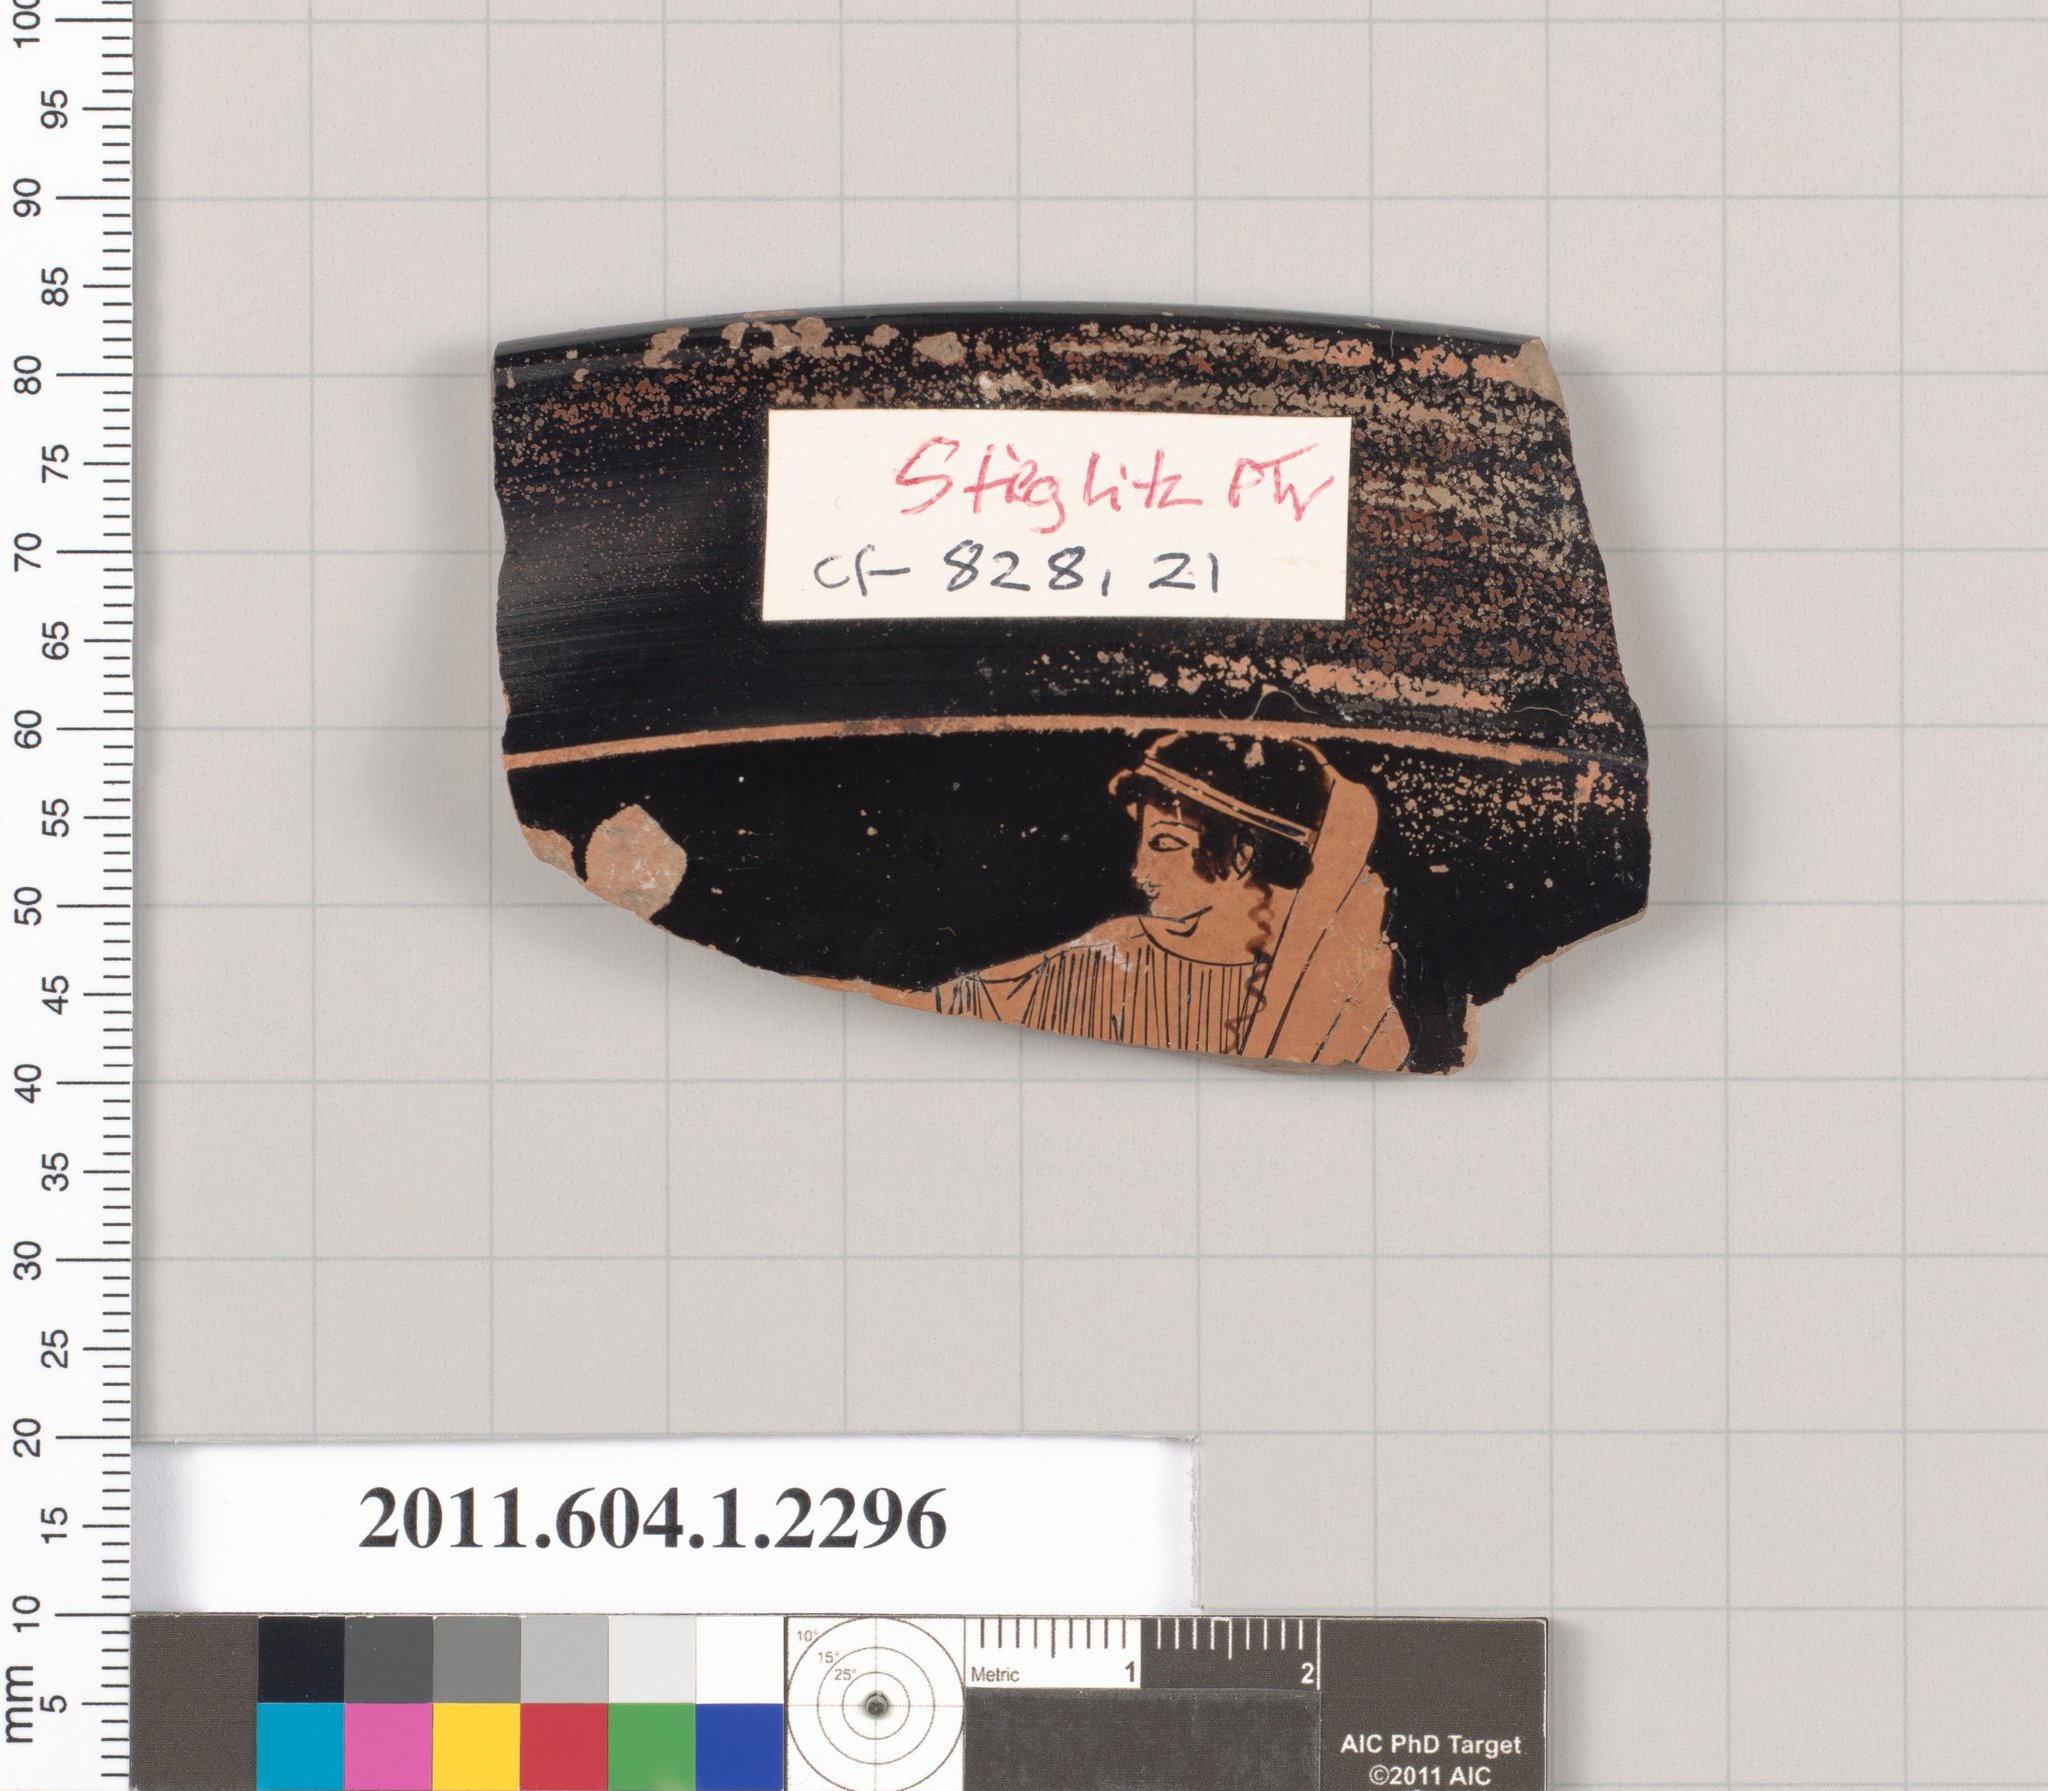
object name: kylix fragment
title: Terracotta rim fragment of a kylix (drinking cup)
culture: greek, attic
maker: stieglitz painter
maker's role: artist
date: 480-470 BCE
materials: terracotta